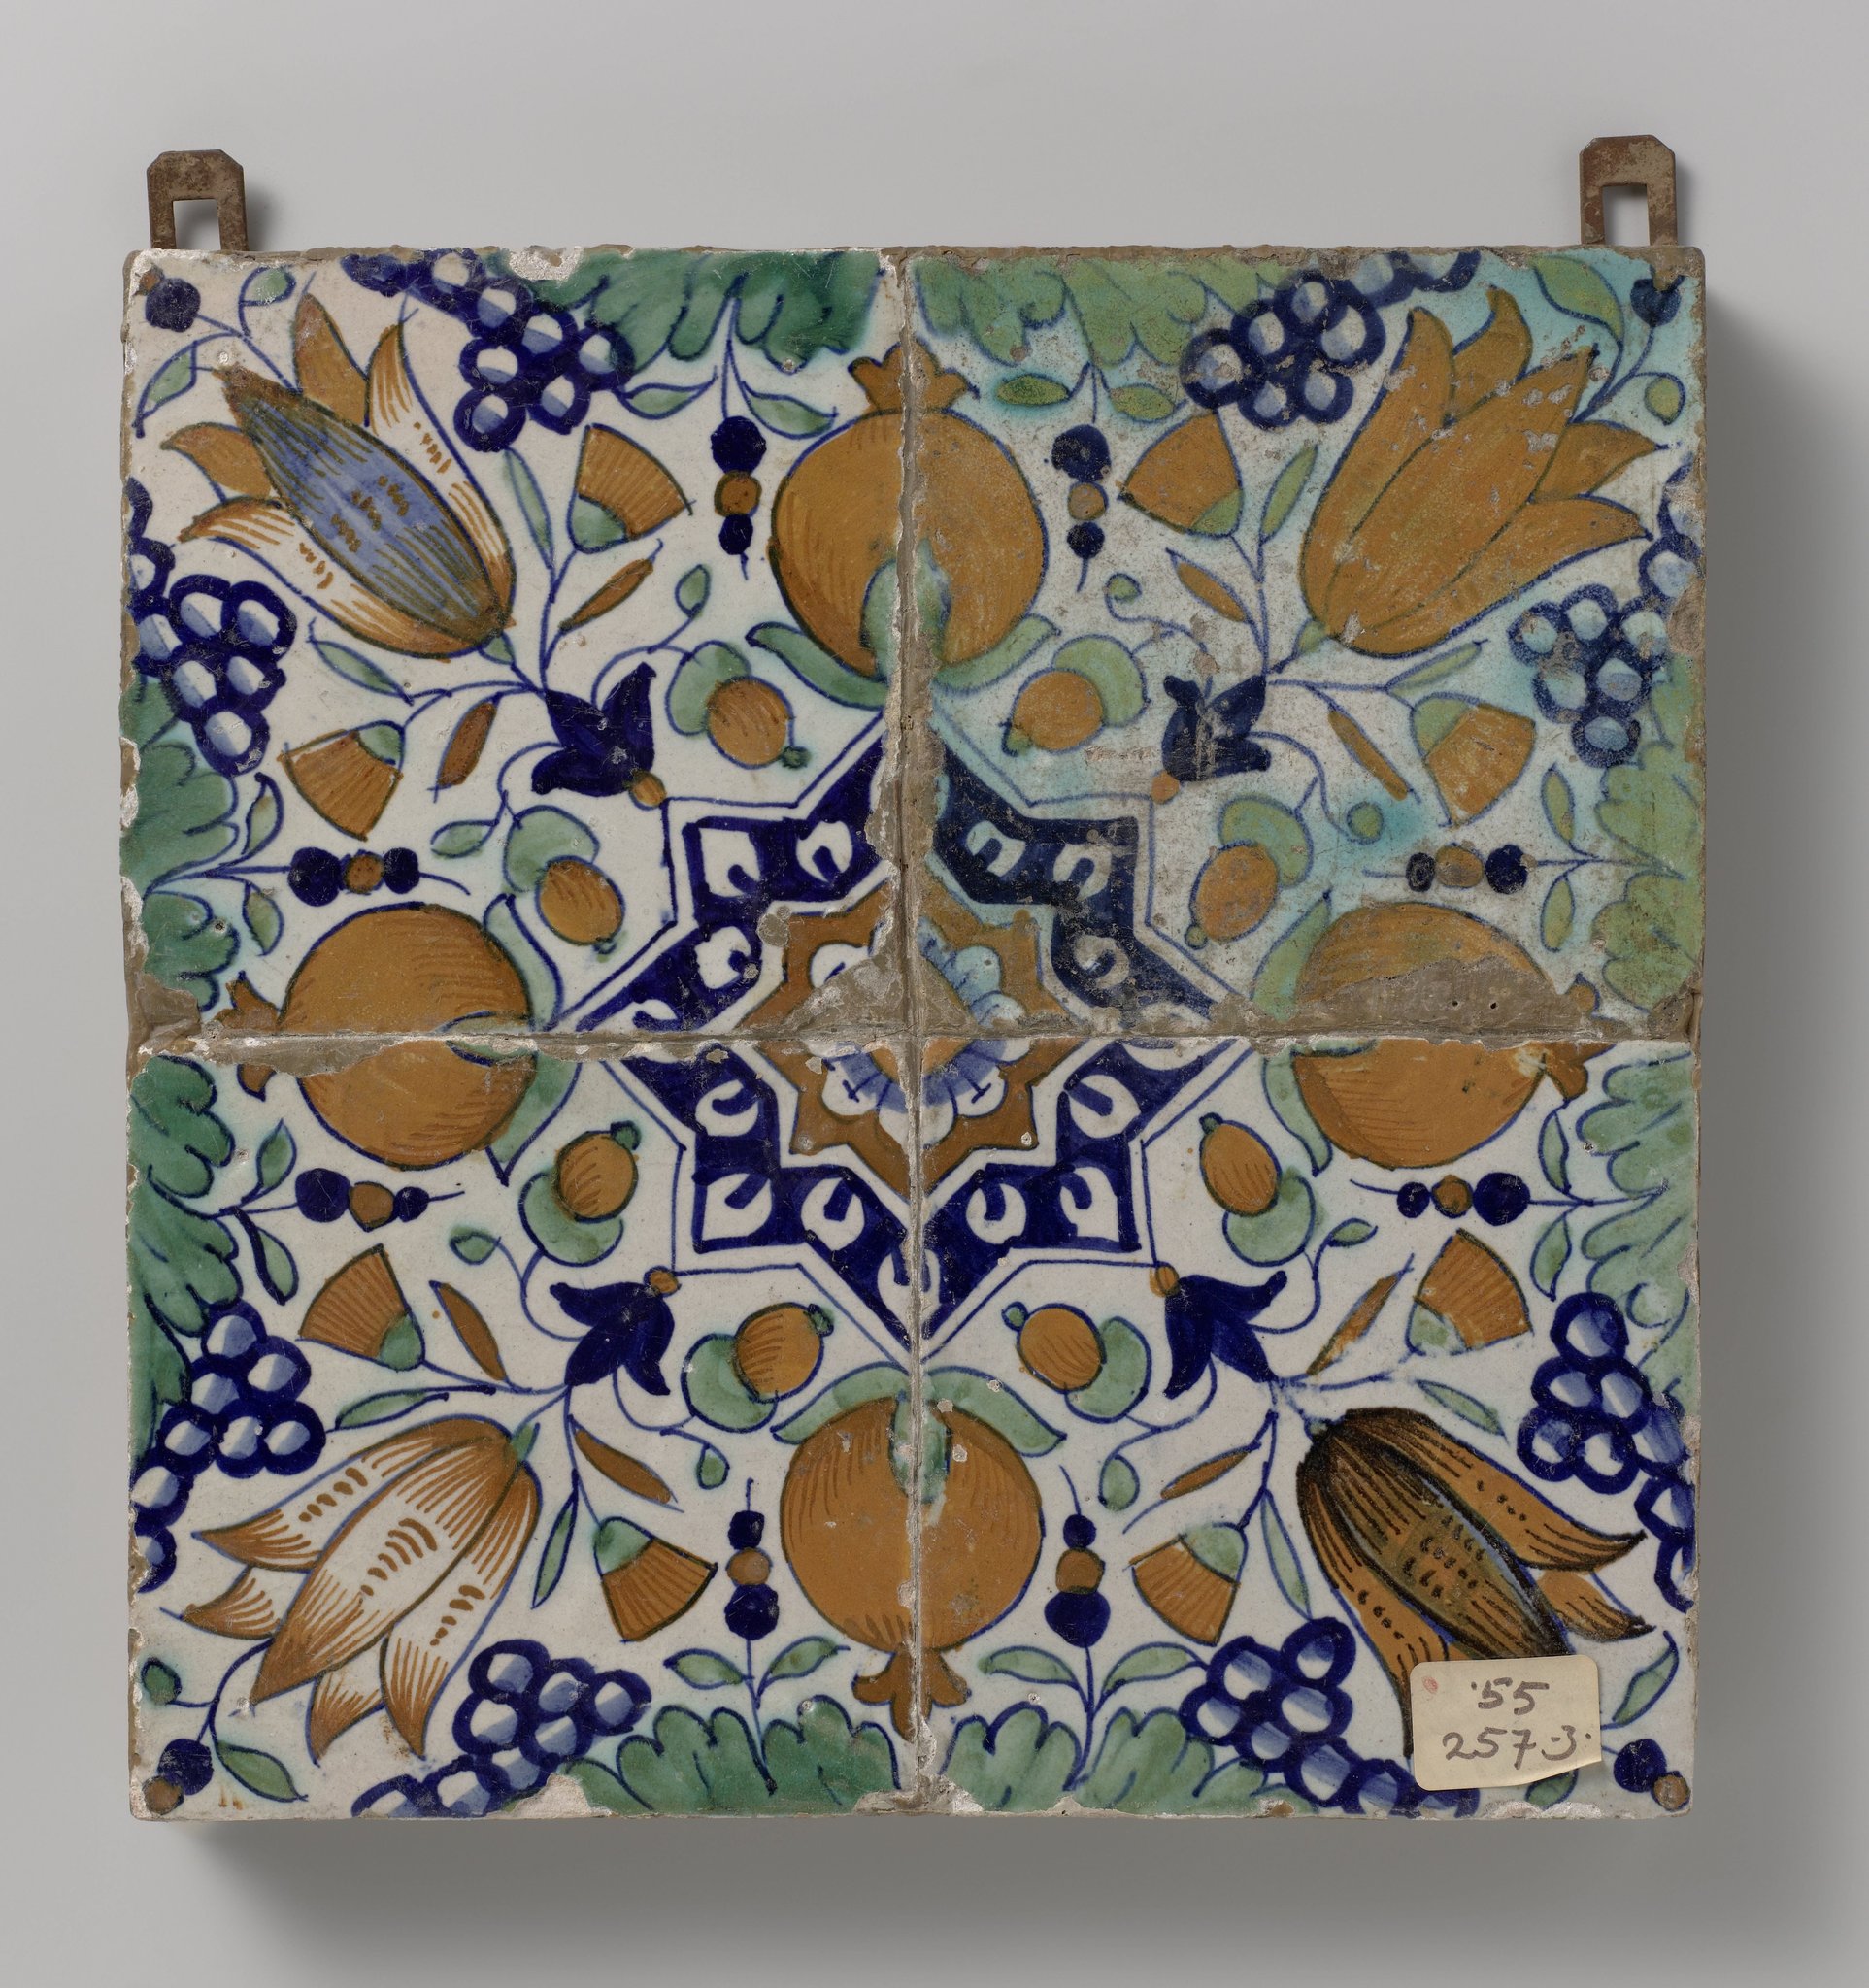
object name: tile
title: Veld van vier tegels met patroon van druiventrossen, granaatappels, tulpen en sterren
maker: Anonymous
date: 1600-1625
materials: earthenware, glaze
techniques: maiolica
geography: netherlands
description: Veld van vier tegels (2 x 2) met een veelkleurig (blauw, groen, geel, oranje en paars) patroon gevormd door vier tegels met granaatappels, druiventrossen en tulpen rond een ster.